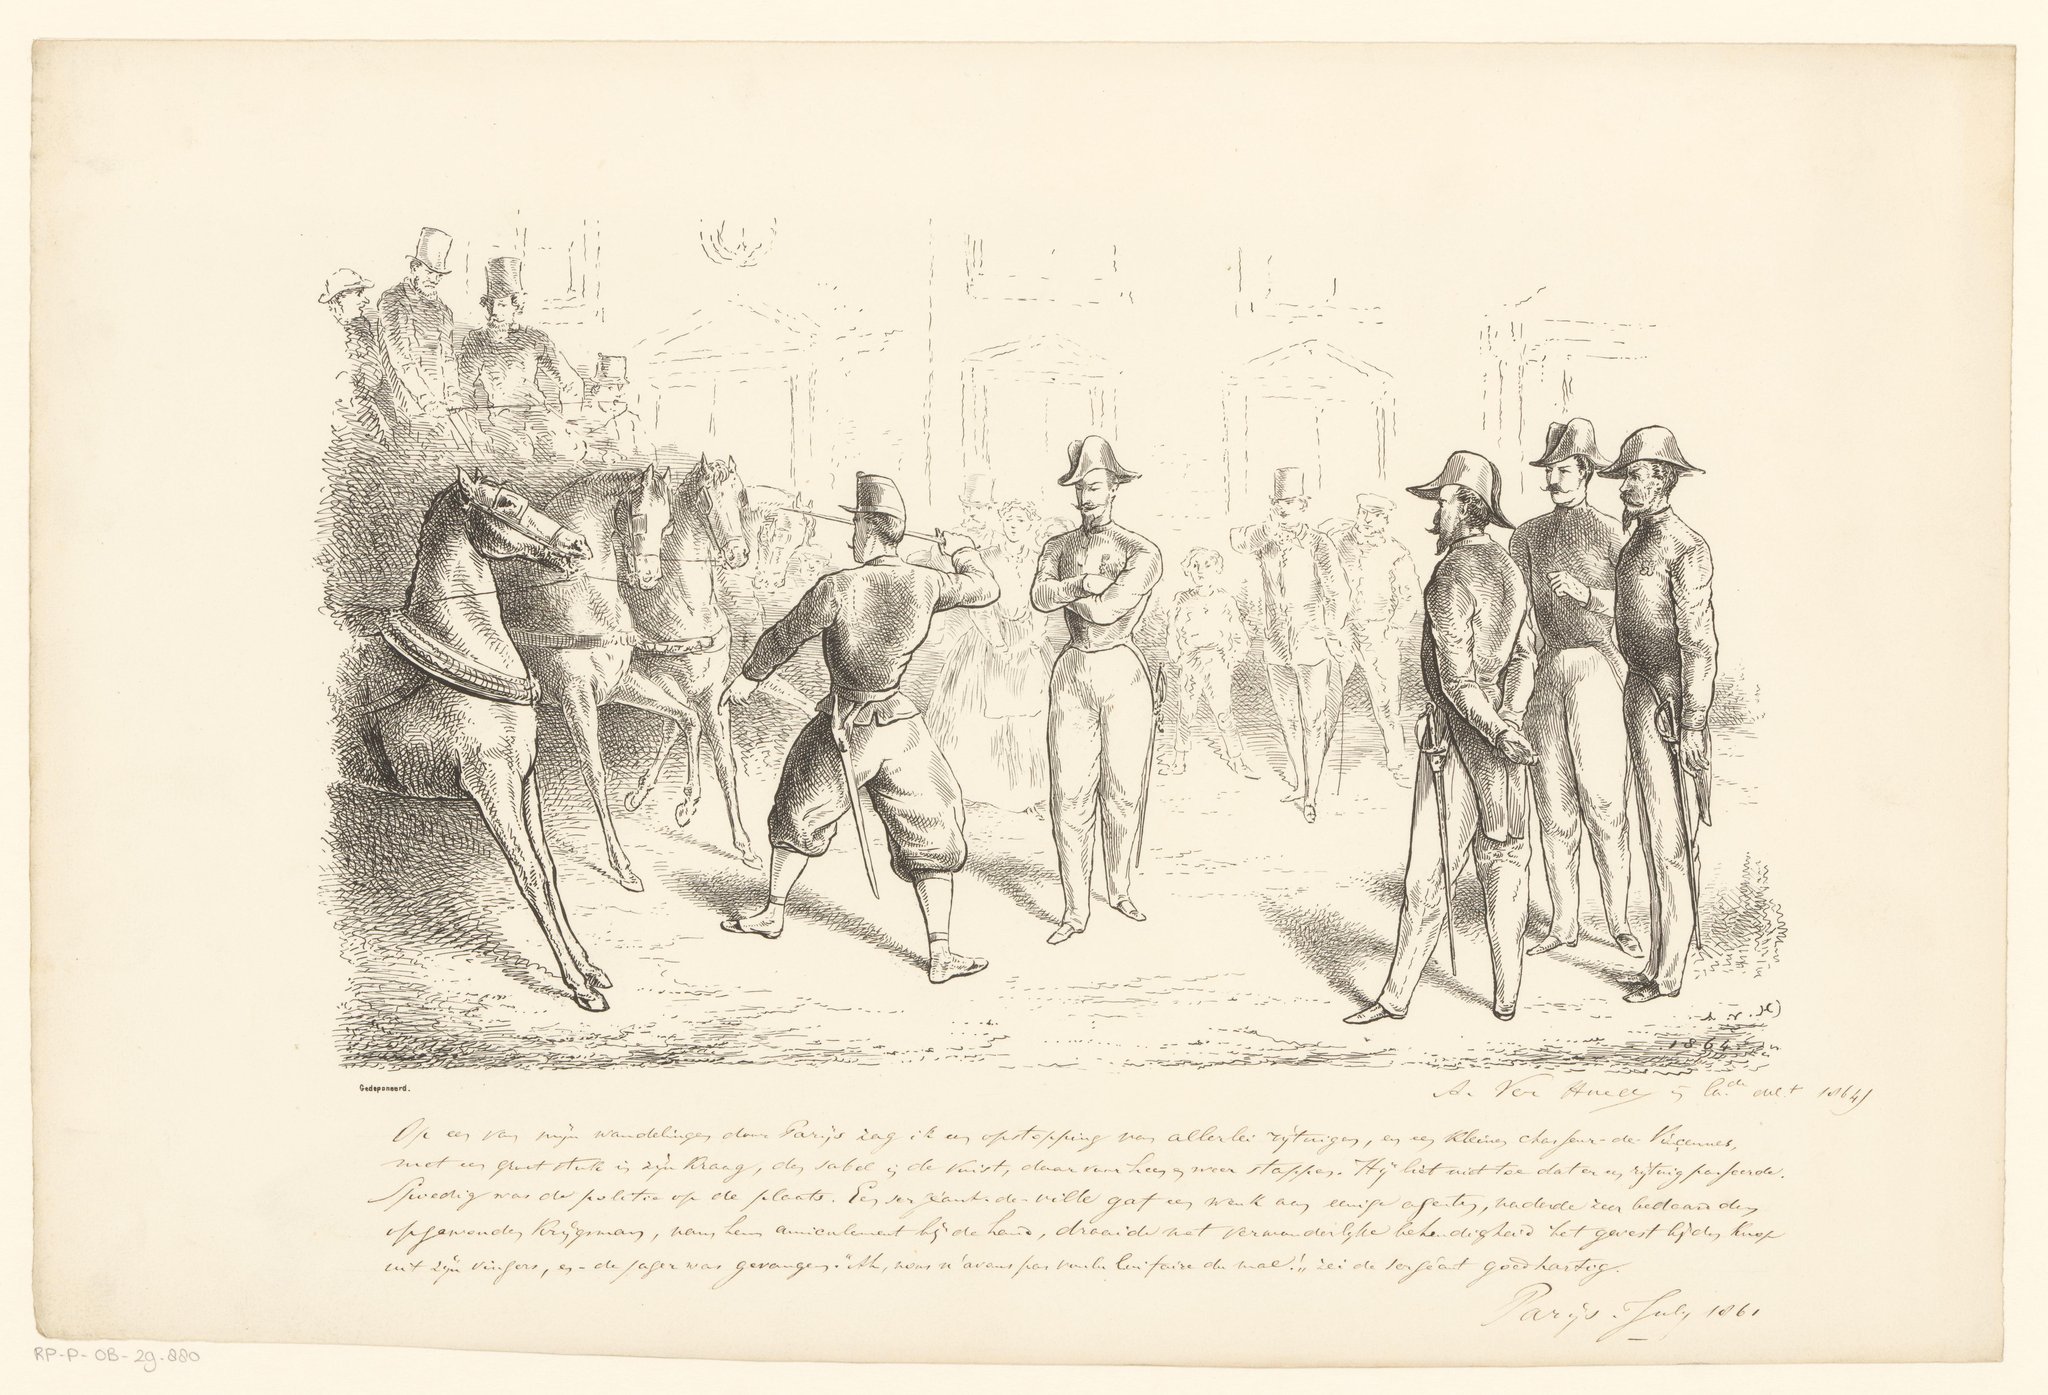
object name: print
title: Uit het verleden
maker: alexander ver huell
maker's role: draughtsman, print maker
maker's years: 1822-1897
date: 1864-1866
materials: paper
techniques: lithograph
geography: arnhem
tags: traffic-block, traffic-jam, policeman, constable, paris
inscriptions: : ‘Gedeponeerd.’, collector's mark: Lugt 2228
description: Een man met sabel verspert de weg voor paarden en wagens. Naast de man staat een politieagent die hem zal bedaren. Omstanders en rechts drie politieagenten kijken toe.